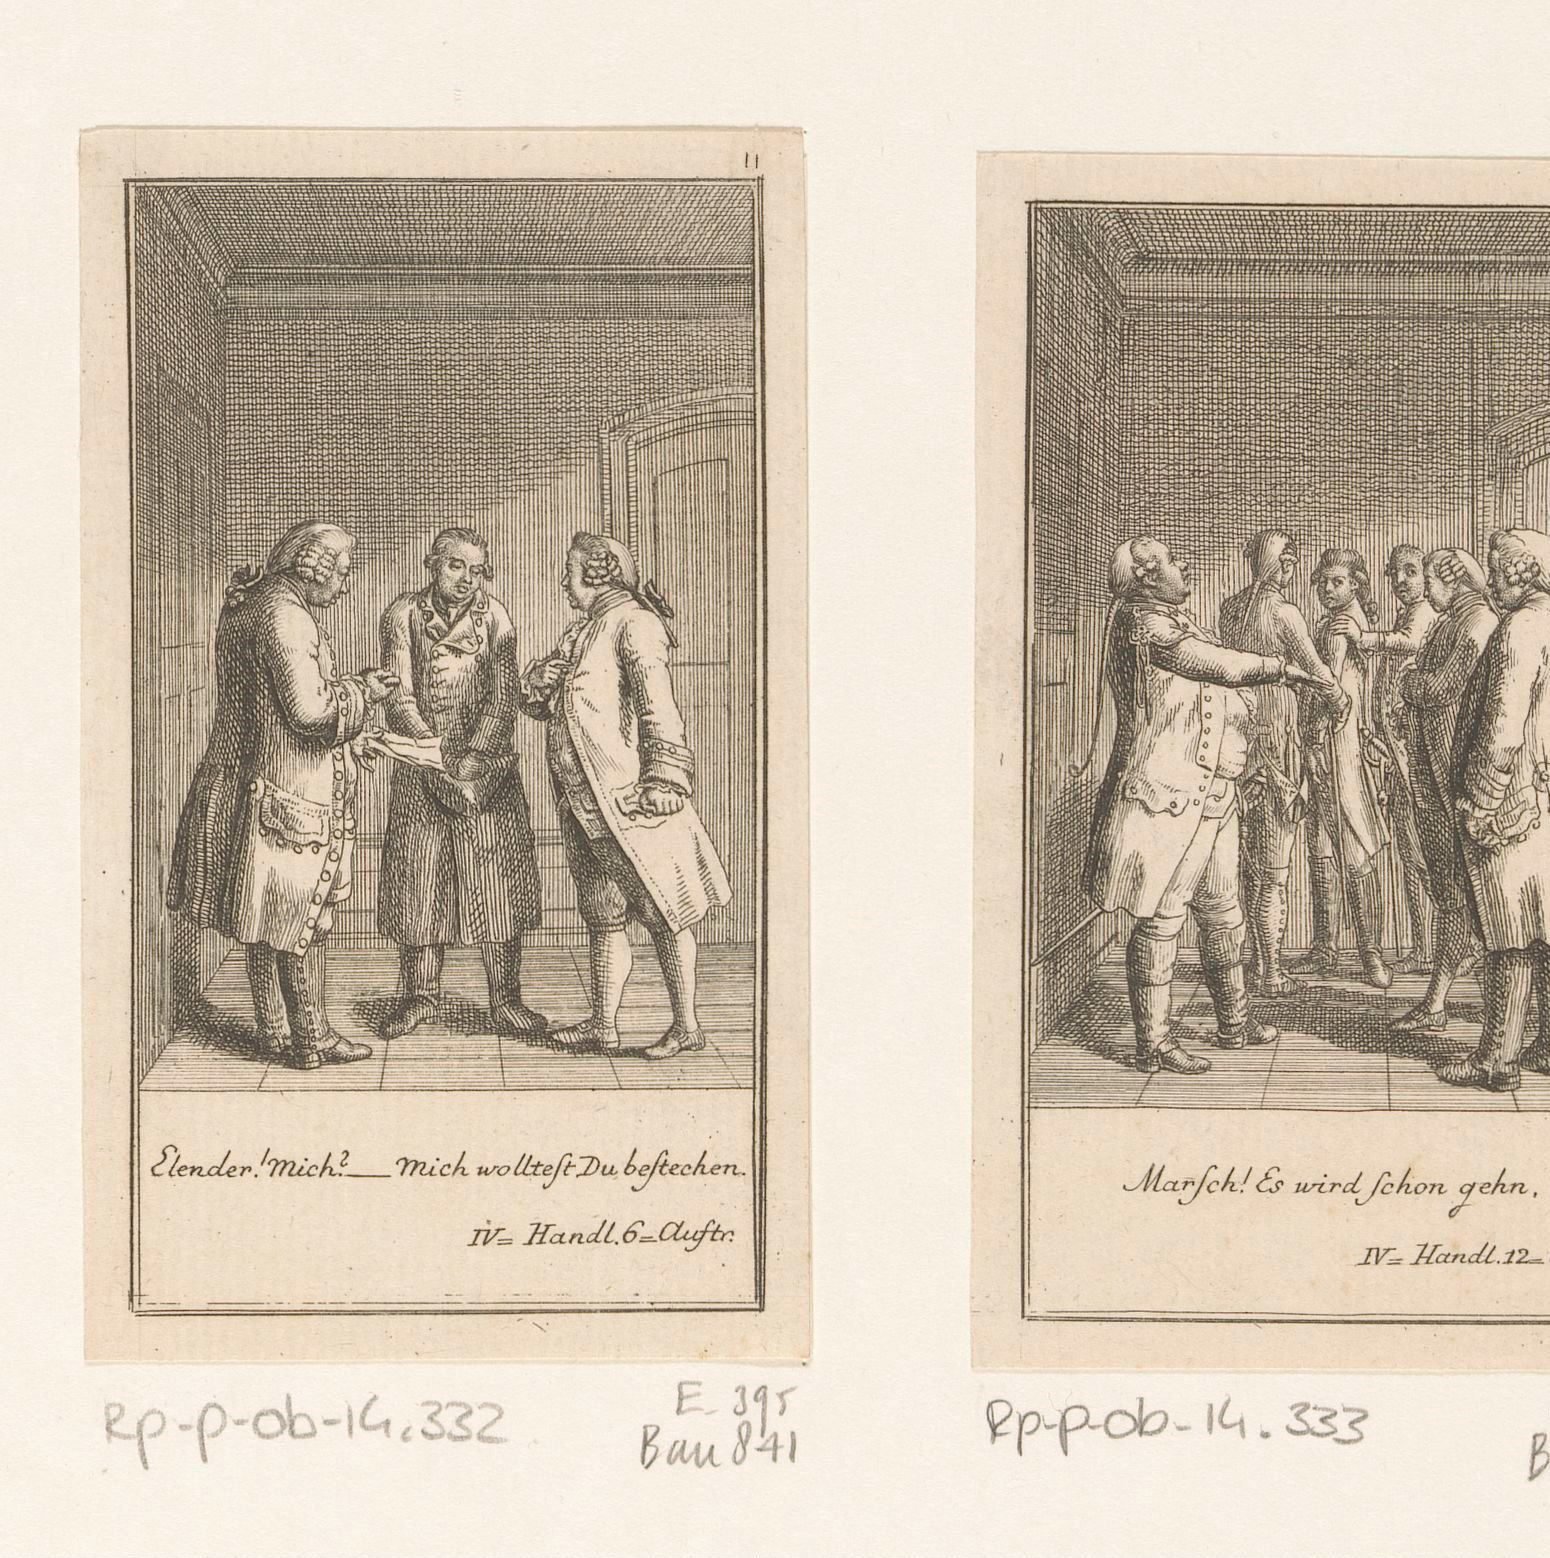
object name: book illustration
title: Reinhard ontdekt dat hij werd omgekocht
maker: daniel nikolaus chodowiecki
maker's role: draughtsman, print maker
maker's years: 1726-1801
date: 1781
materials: paper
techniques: etching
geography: berlin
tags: berlin, conversation, dialogue; conversation piece, bribery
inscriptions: collector's mark: Lugt 2228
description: Vervaardigd voor G. F. W. Grossmann's 'Nicht mehr als sechs Schüsseln'. Prent gebruikt voor: Königl. Grossbr. Genealogischer Kalender auf das Jahr 1782. Lauenburger: J.G. Berenberg, 1782.